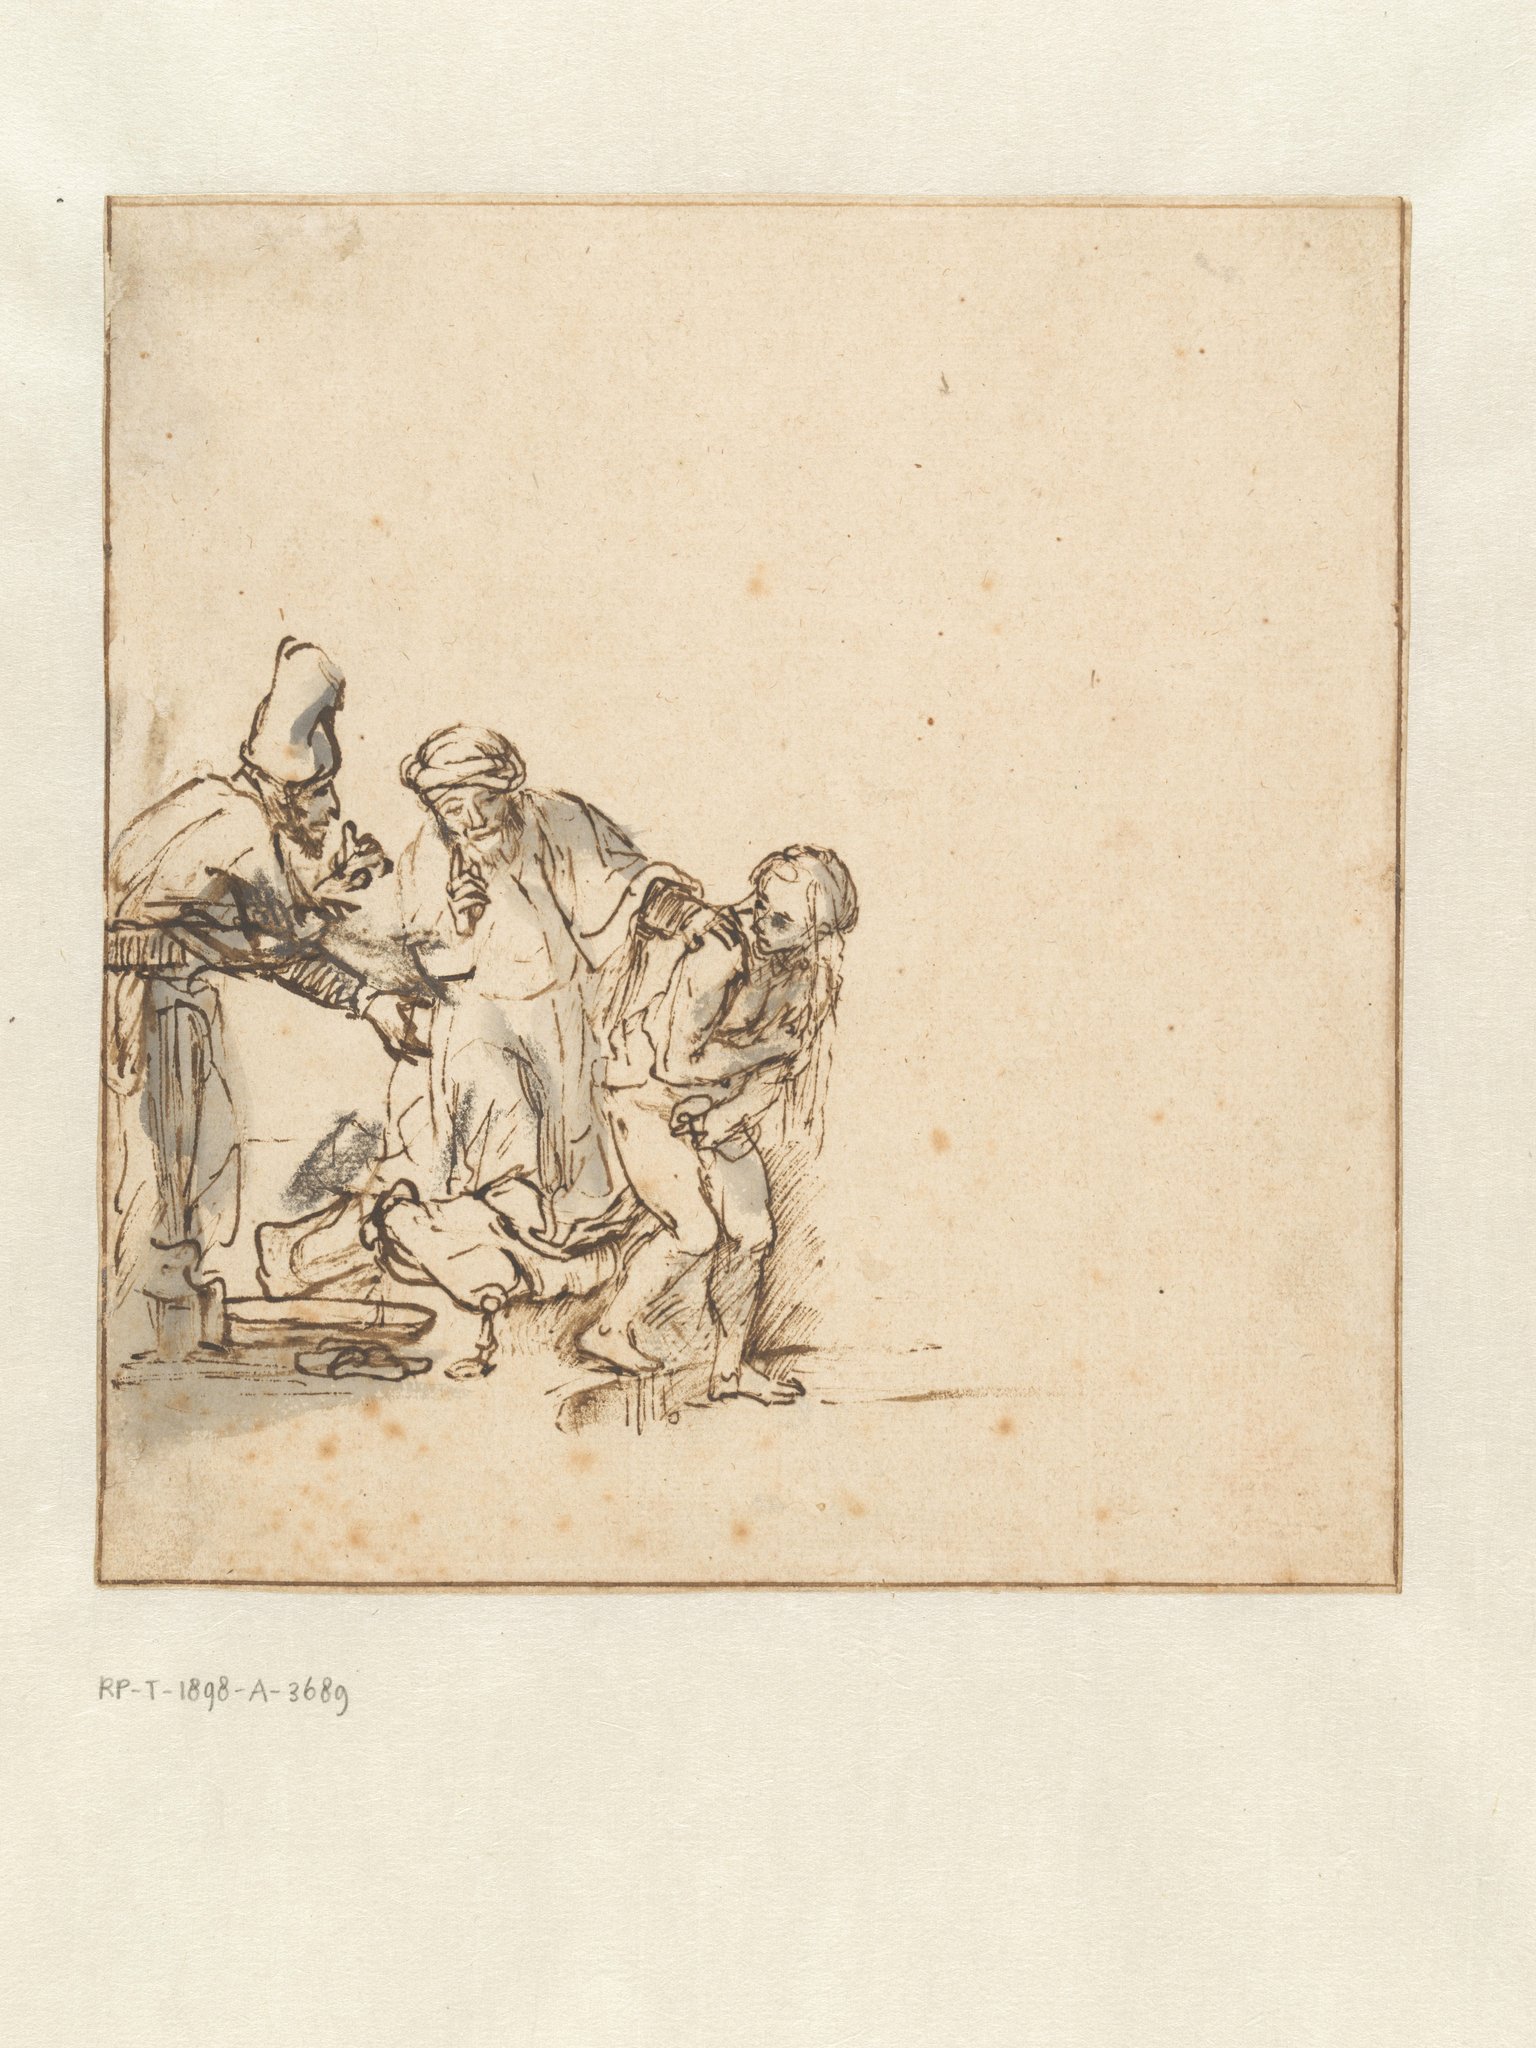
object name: drawing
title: Susanna and the Elders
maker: rembrandt van rijn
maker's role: draughtsman, painter, print maker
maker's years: 1606-1669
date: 1650-1655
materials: paint, ink, paper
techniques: brush, pen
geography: amsterdam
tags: the elders spying upon susanna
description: While bathing, the beautiful Susanna was accosted by two elders, who threatened to accuse her of adultery if she refused their advances. Rembrandt succeeded masterfully in conveying the unsavoury contrast between the position of power of the treacherous men laying their hands on Susanna and her own vulnerability. The man staring intently at her clothing on the ground emphasizes her nudity.